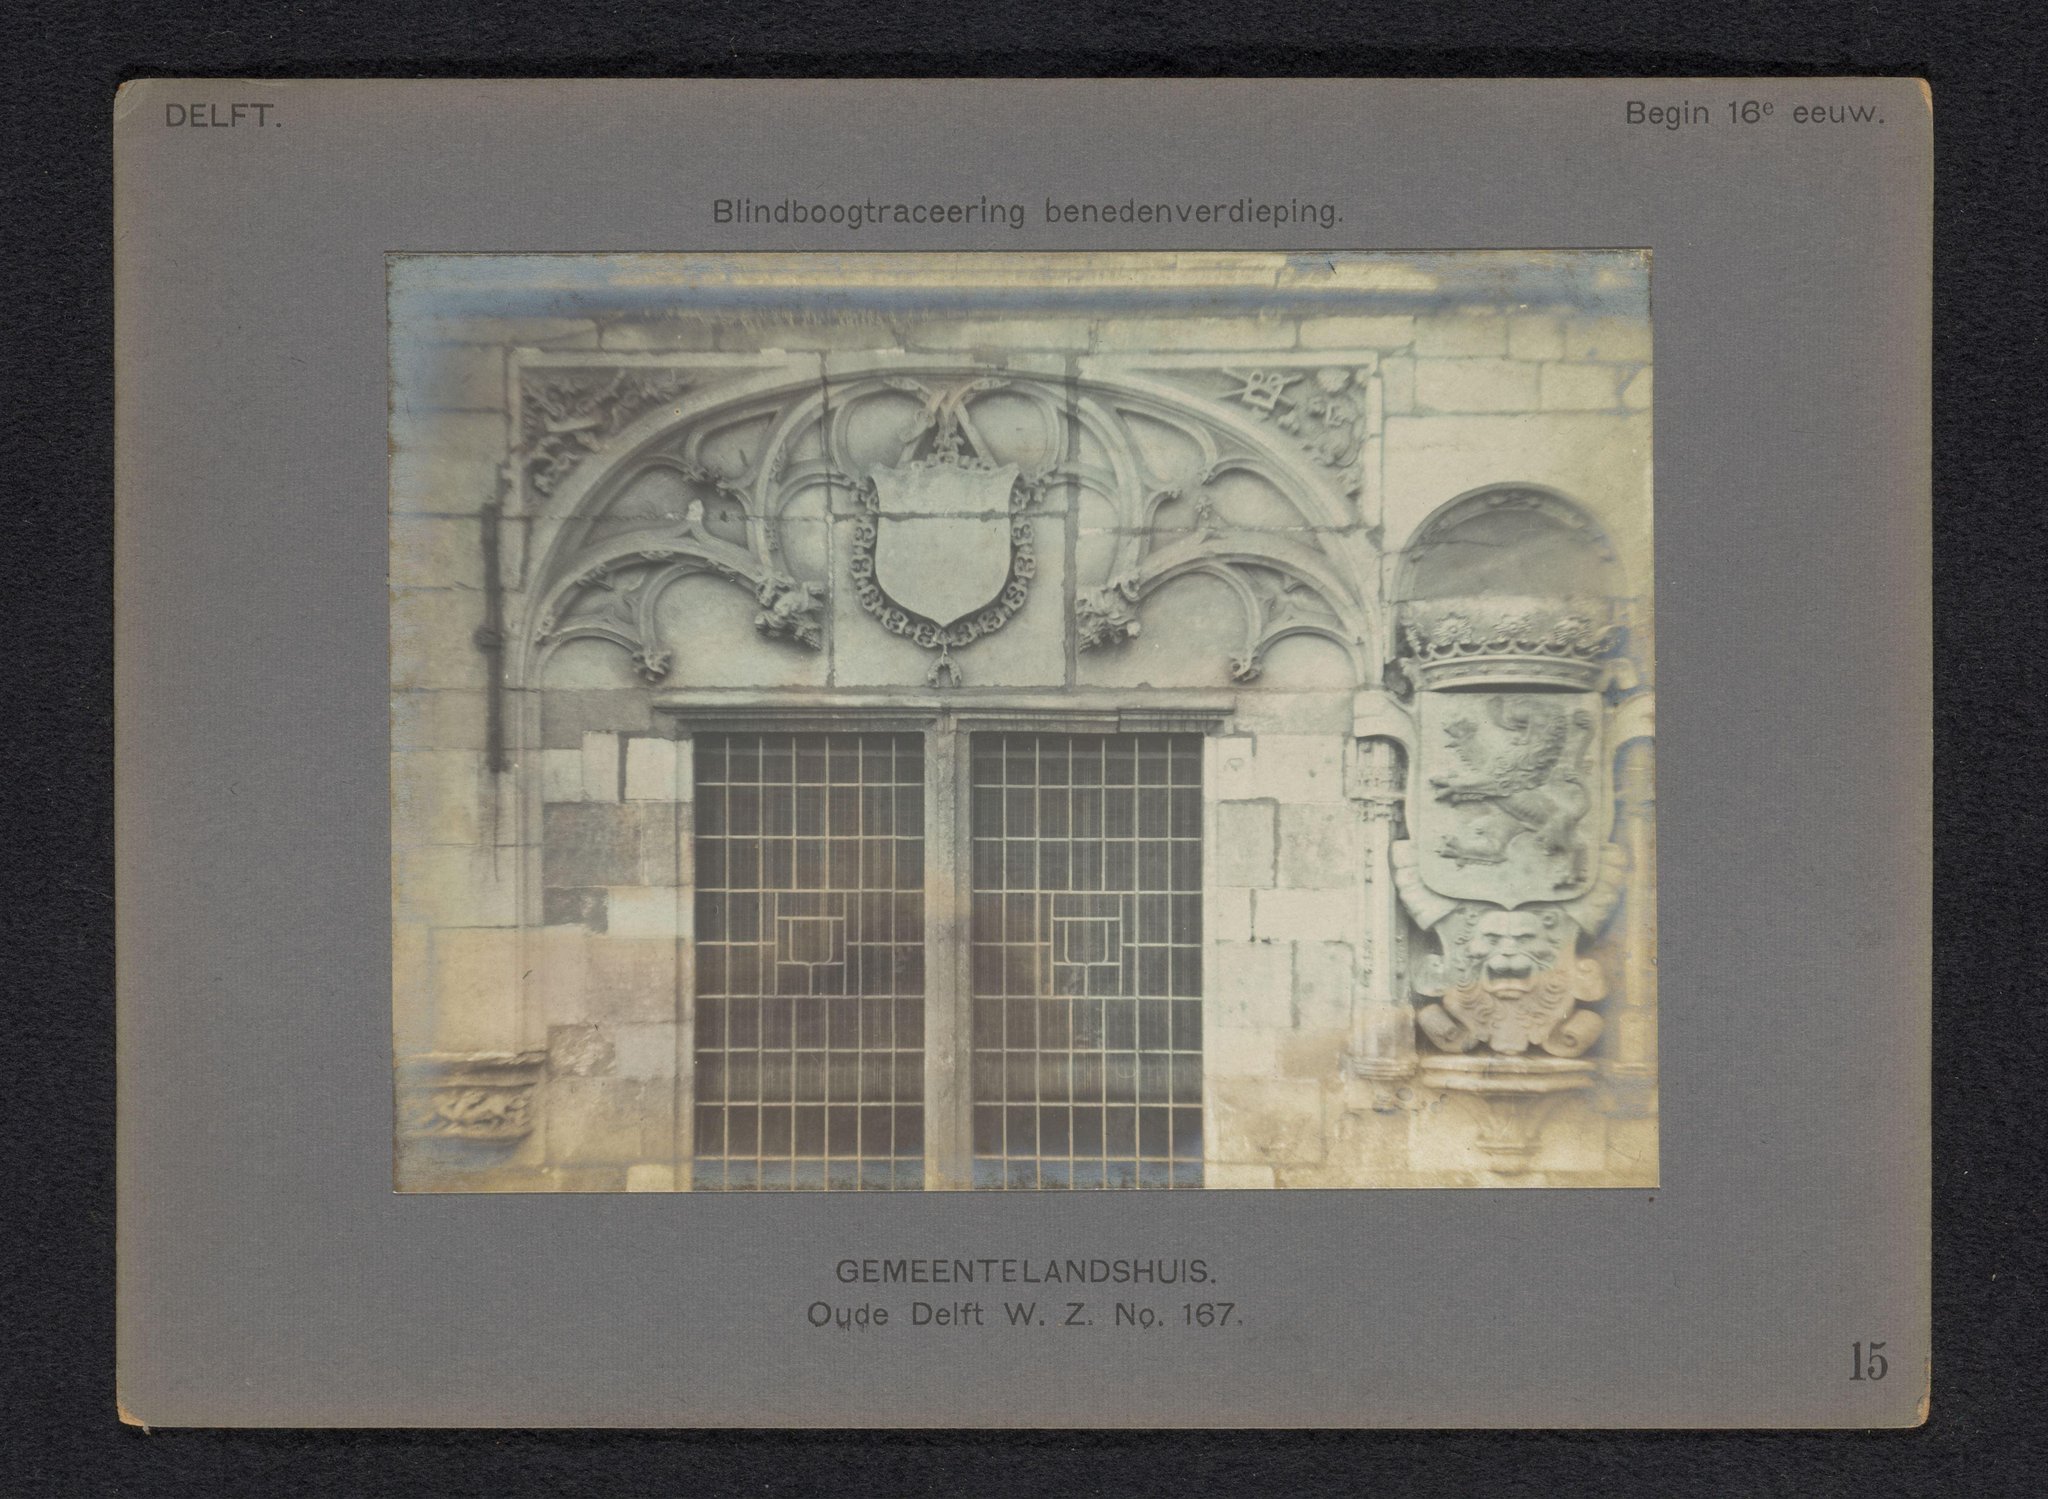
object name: photograph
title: Ramen van het Gemeenlandshuis aan de Oude Delft in Delft gedecoreerd met bogen, bladmotieven en wapenschilden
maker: Anonymous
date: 1900-1904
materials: cardboard, photographic support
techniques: gelatin silver print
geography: delft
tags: coat of arms (as symbol of the state, etc.), closed window, ornament derived from plant forms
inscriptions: inscription: ‘Delft. Begin 16e eeuw.’, inscription: ‘Het recht van reproductie dezer photo's wordt door den Uitgever voorbehouden.’, number: ‘15’